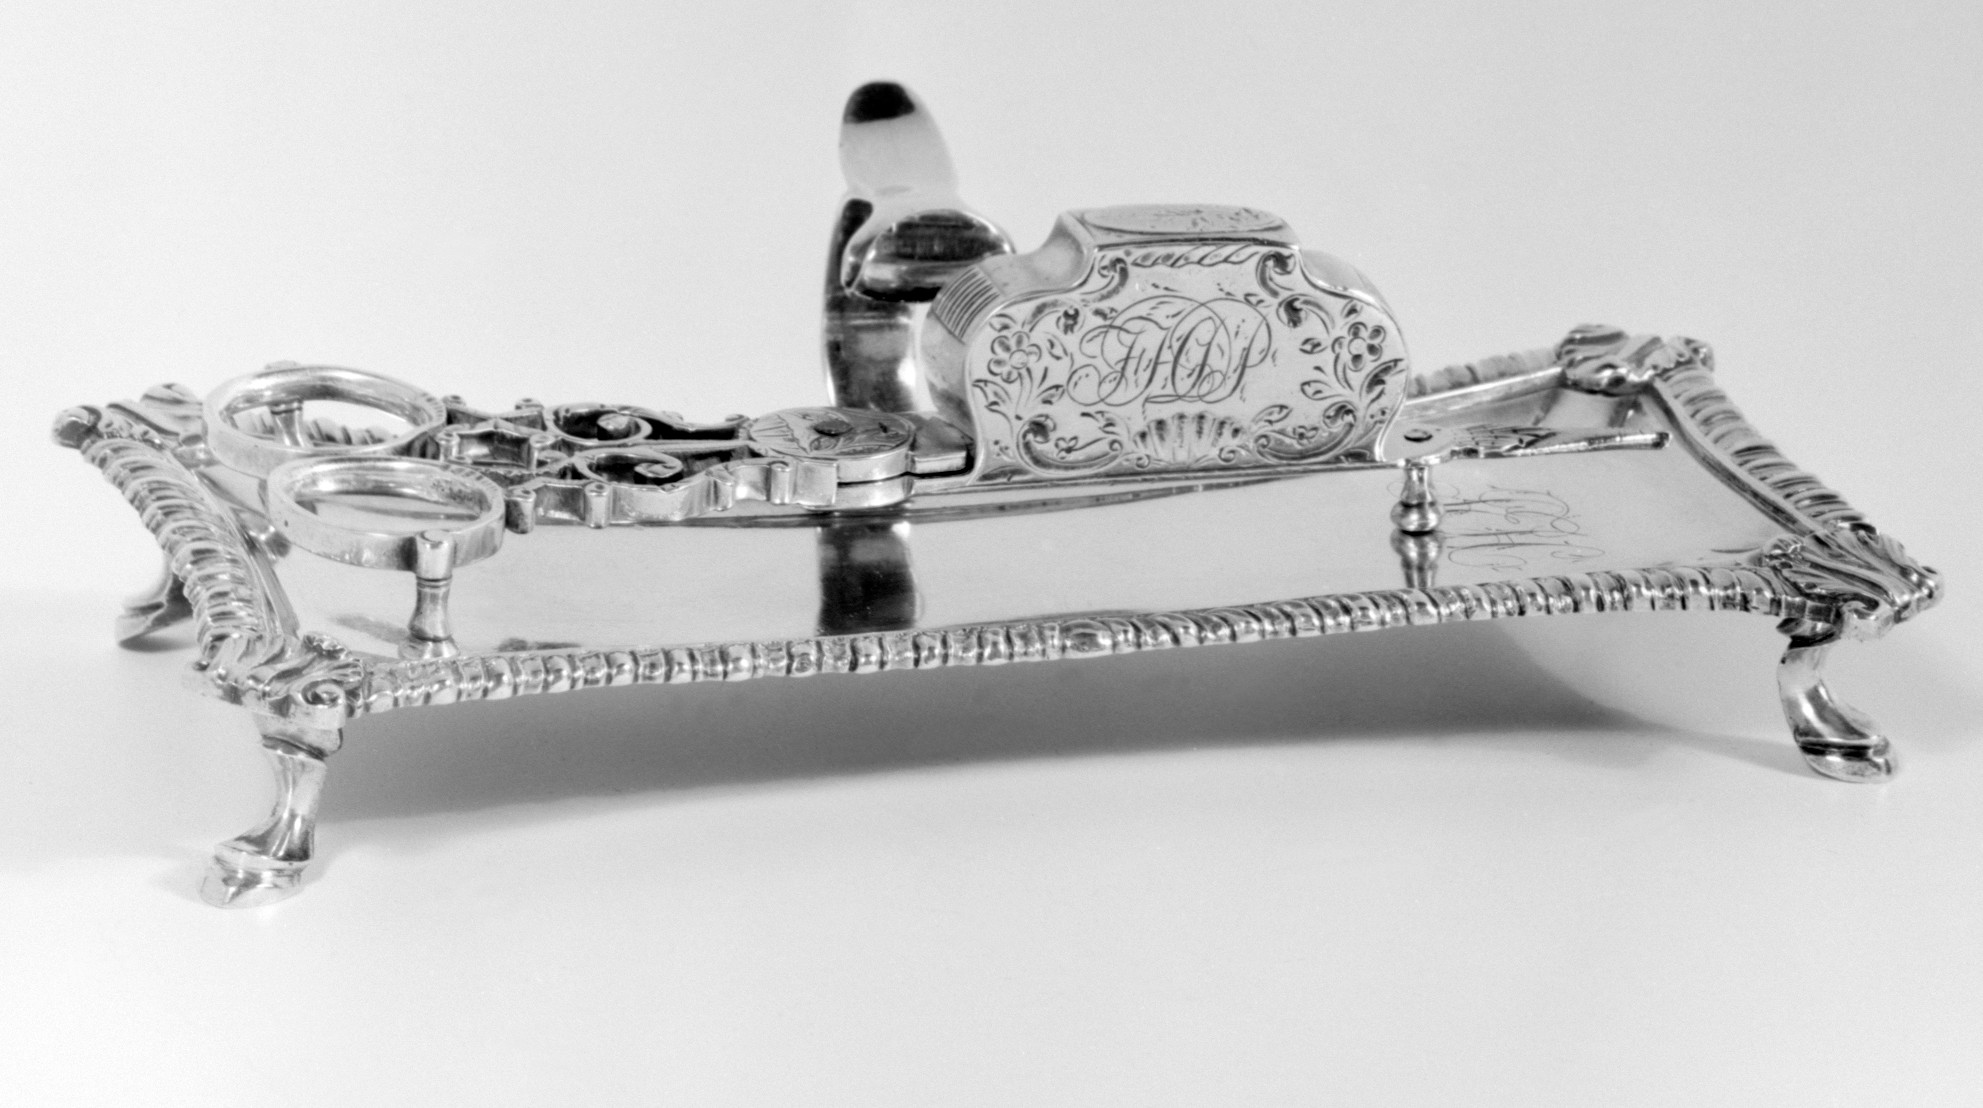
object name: snuffer tray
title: Snuffers tray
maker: w. t., london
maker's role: maker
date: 1765-1766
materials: silver